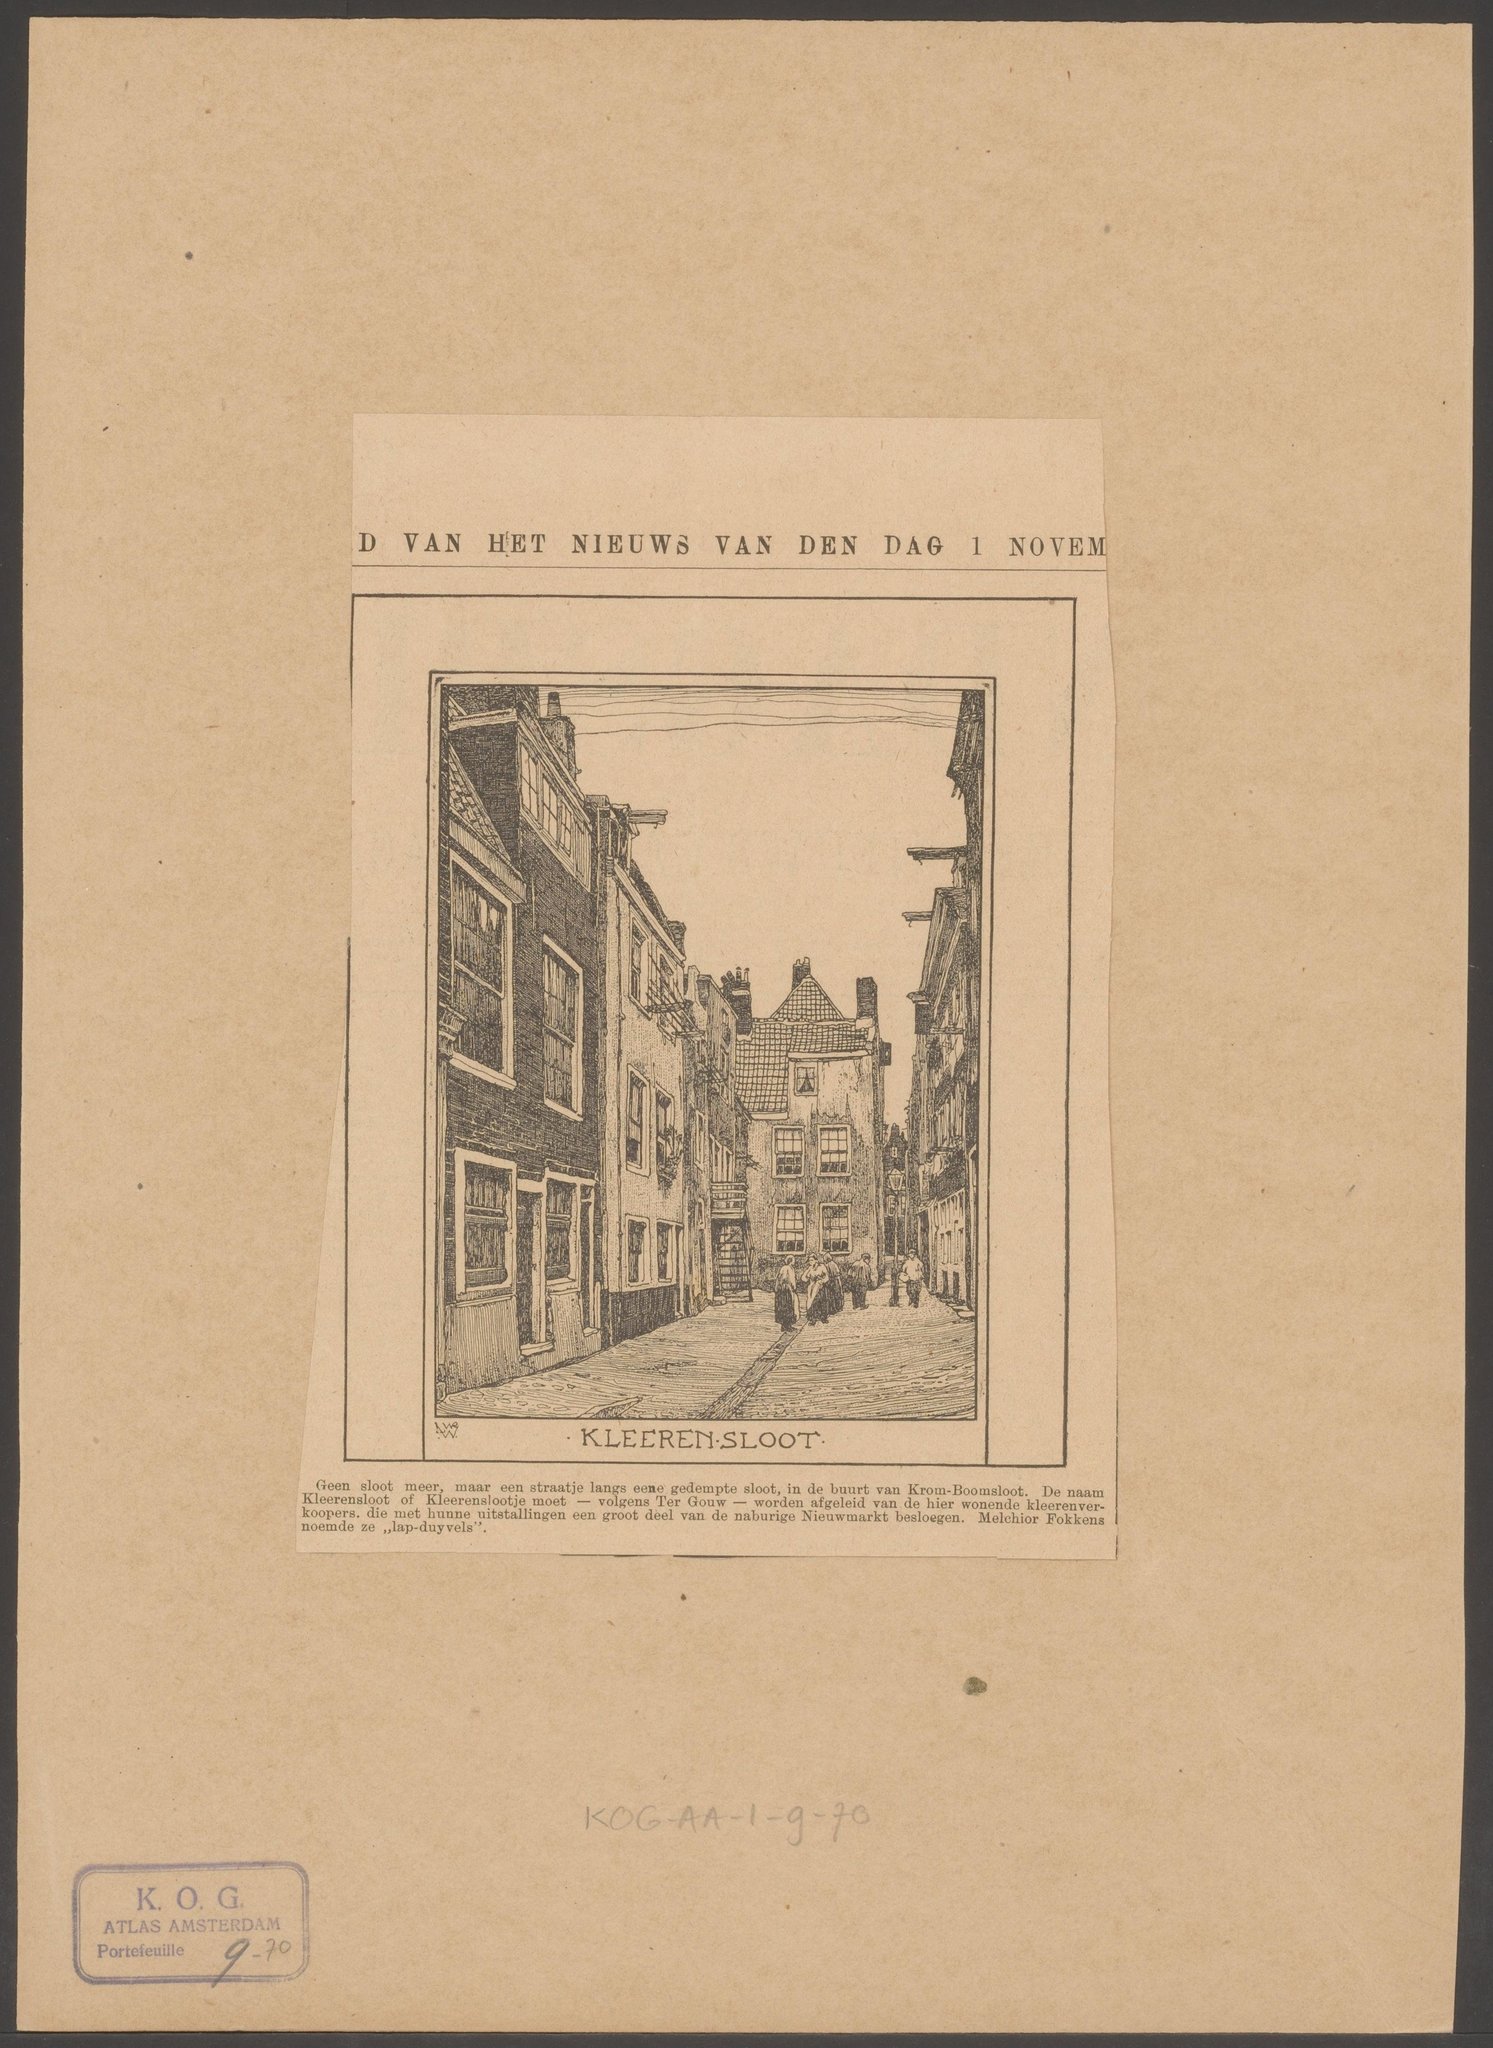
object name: photomechanical print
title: Oud-Amsterdam 100 Stadsgezichten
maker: willem wenckebach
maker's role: designer, draughtsman, painter, print maker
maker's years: 1860-1937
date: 1870-1923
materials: paper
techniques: letterpress printing, line block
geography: amsterdam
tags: city-view in general; 'veduta', the usual house or row of houses, street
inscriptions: collector's mark: ‘9-70’ Lugt 1641b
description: Onderwerpsrubriek binnen de Atlas Amsterdam: Kadijksplein, Karthuizerkerkhof, Kattegat, Kattenburg, Kapelsteeg O.Z., Enge Kerksteeg, Kerkstraat, Kinkerstraat, Kolk O.Z., Koningsplein, Kromboomsloot [Krom Boomssloot], Kostverlorenkade, Kwakersdwarspad, Kalverstraat, Keizersgracht (v.d. Brouwersgracht – Amstel), Klerensloot (Gedempte), Klimopstraat, Kloveniersburgwal, Kraansluis.